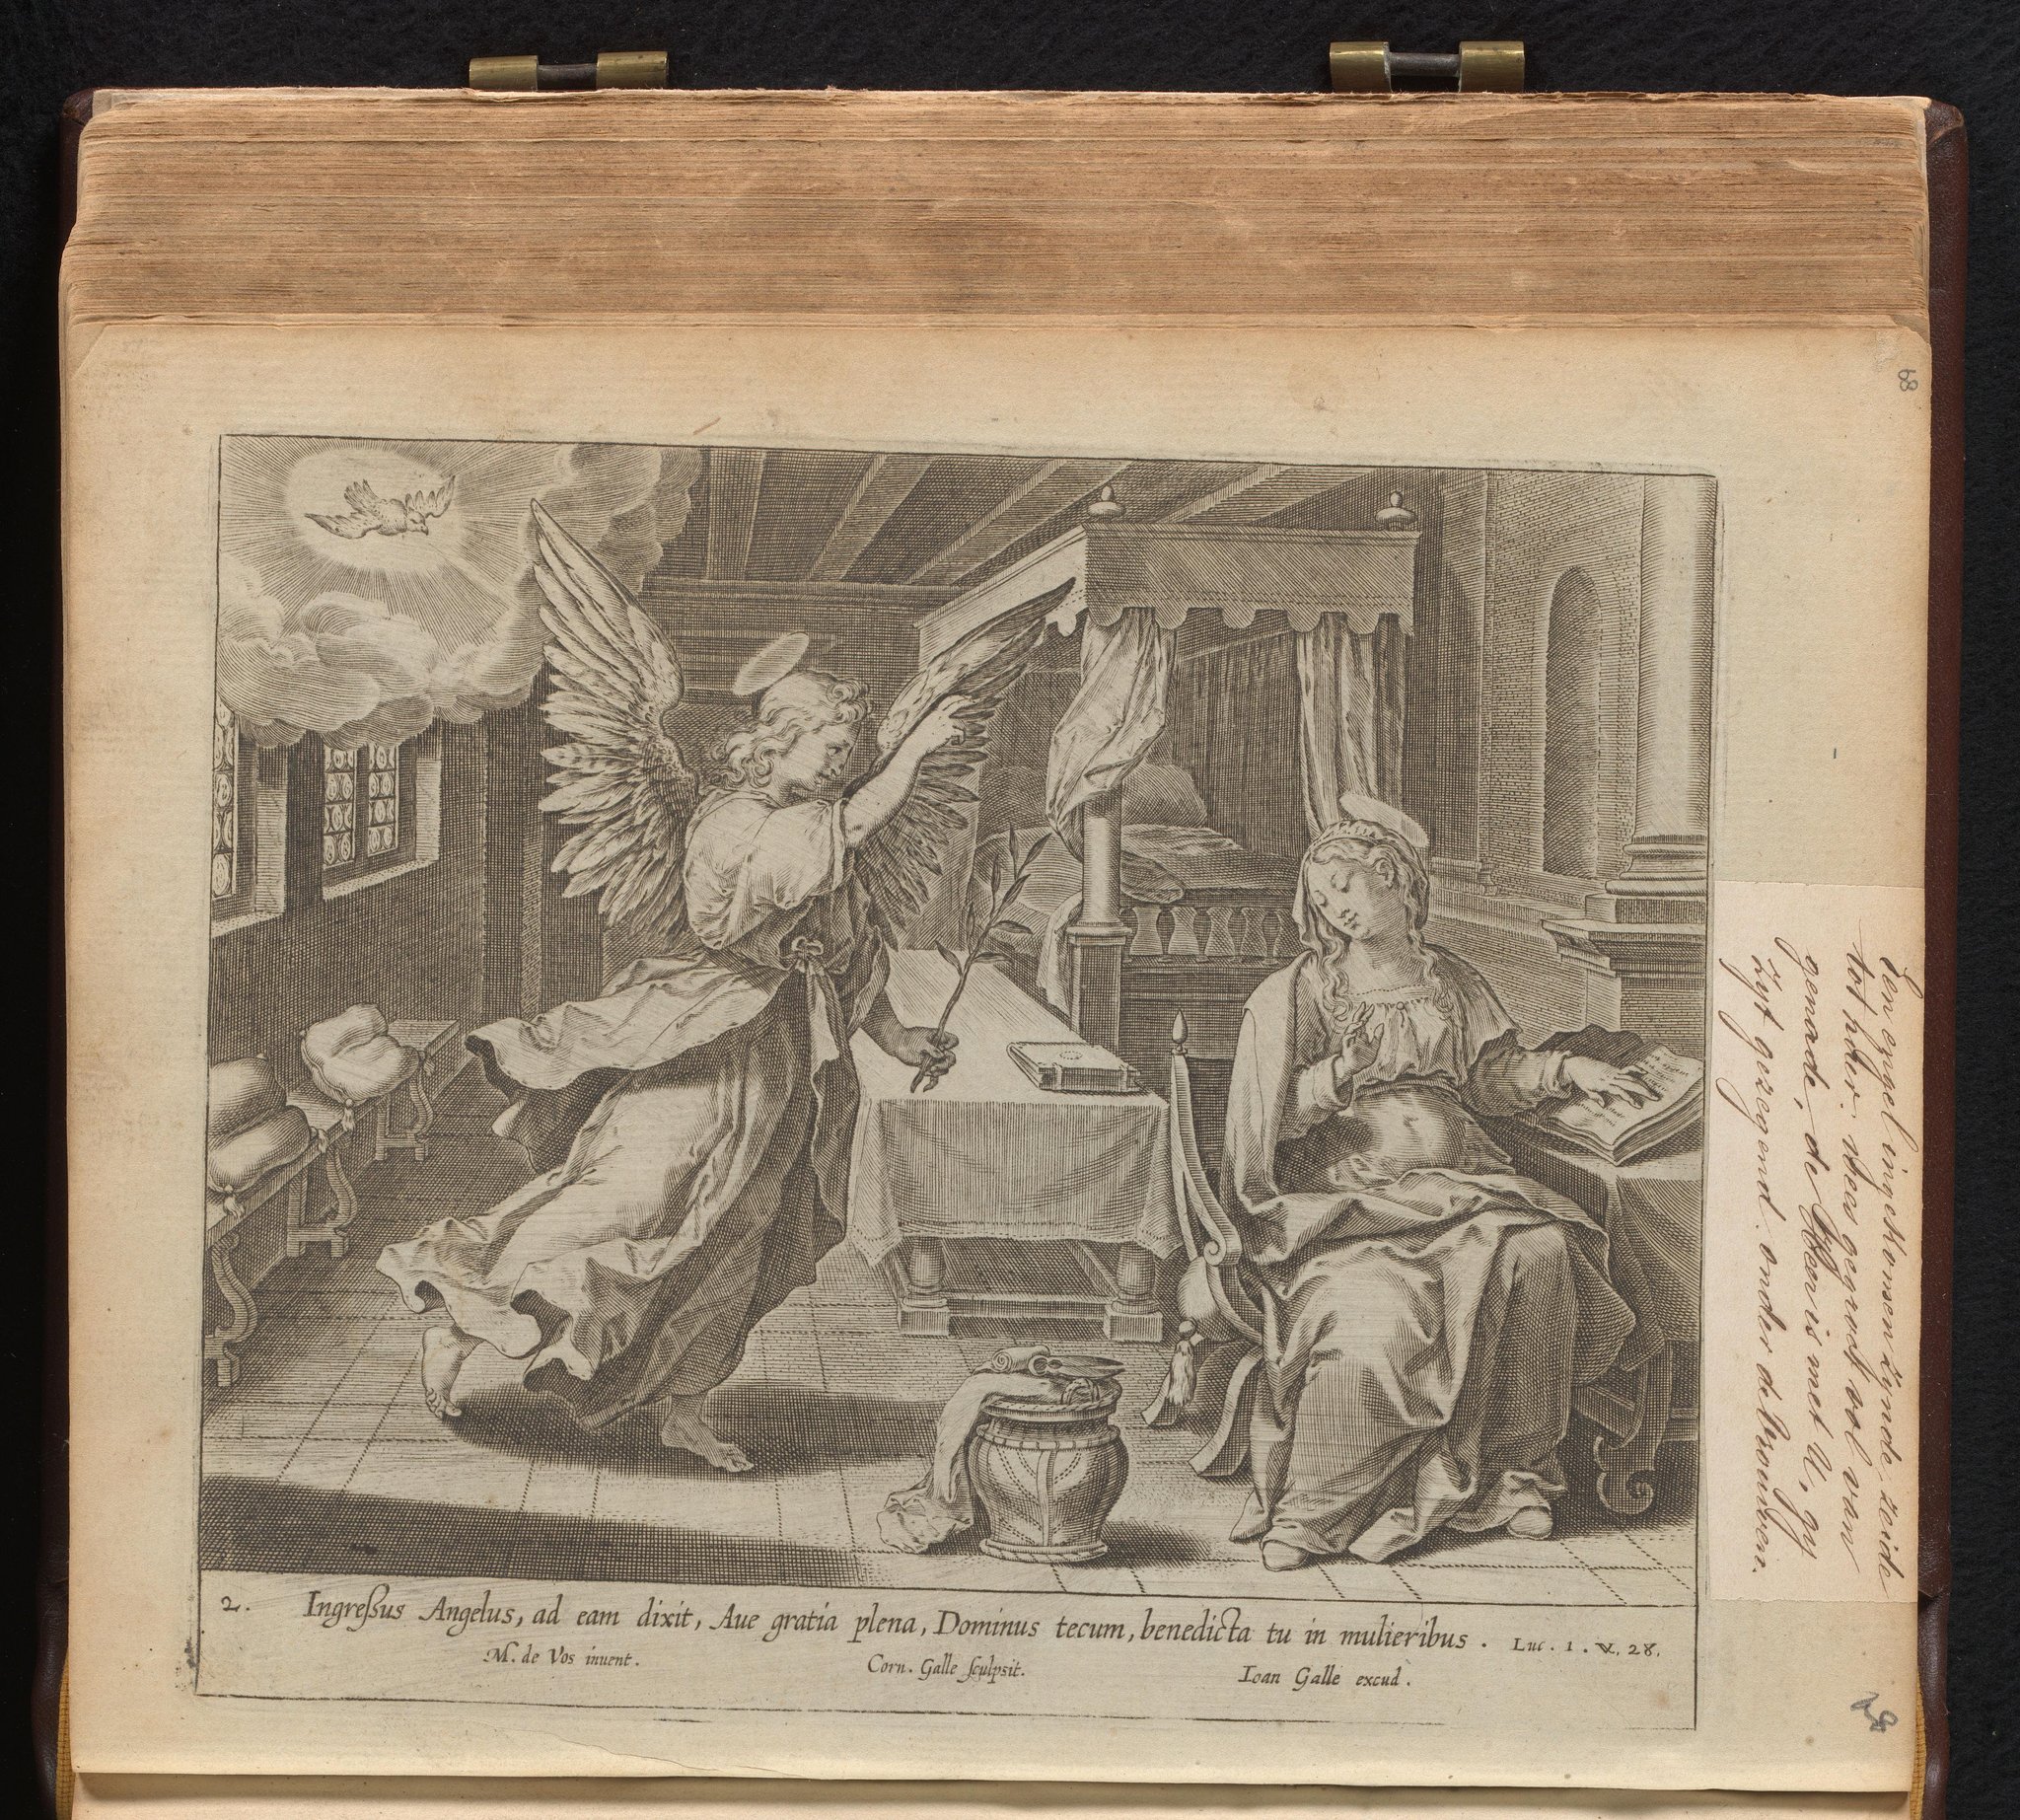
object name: album leaf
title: Leven, passie en wederopstanding van Christus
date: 1598-1618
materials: paper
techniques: engraving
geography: antwerp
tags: the annunciation: mary sitting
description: Prent maakt deel uit van een prentbijbel.